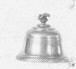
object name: bell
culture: italian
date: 1801-1900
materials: metal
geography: italy